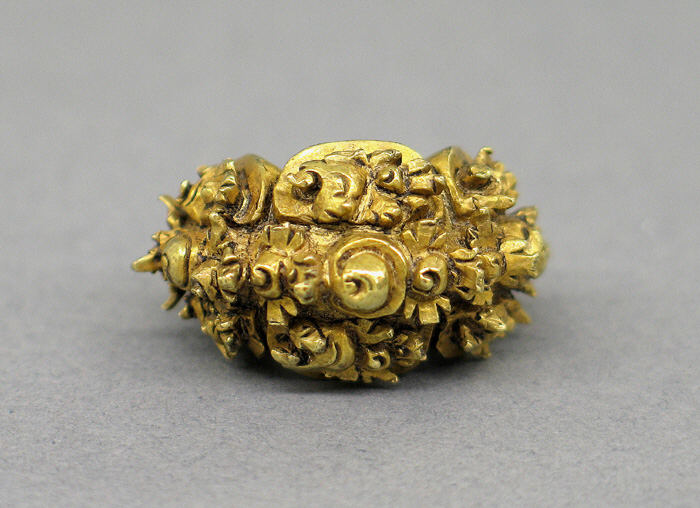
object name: ear ornament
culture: indonesian, javanese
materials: gold